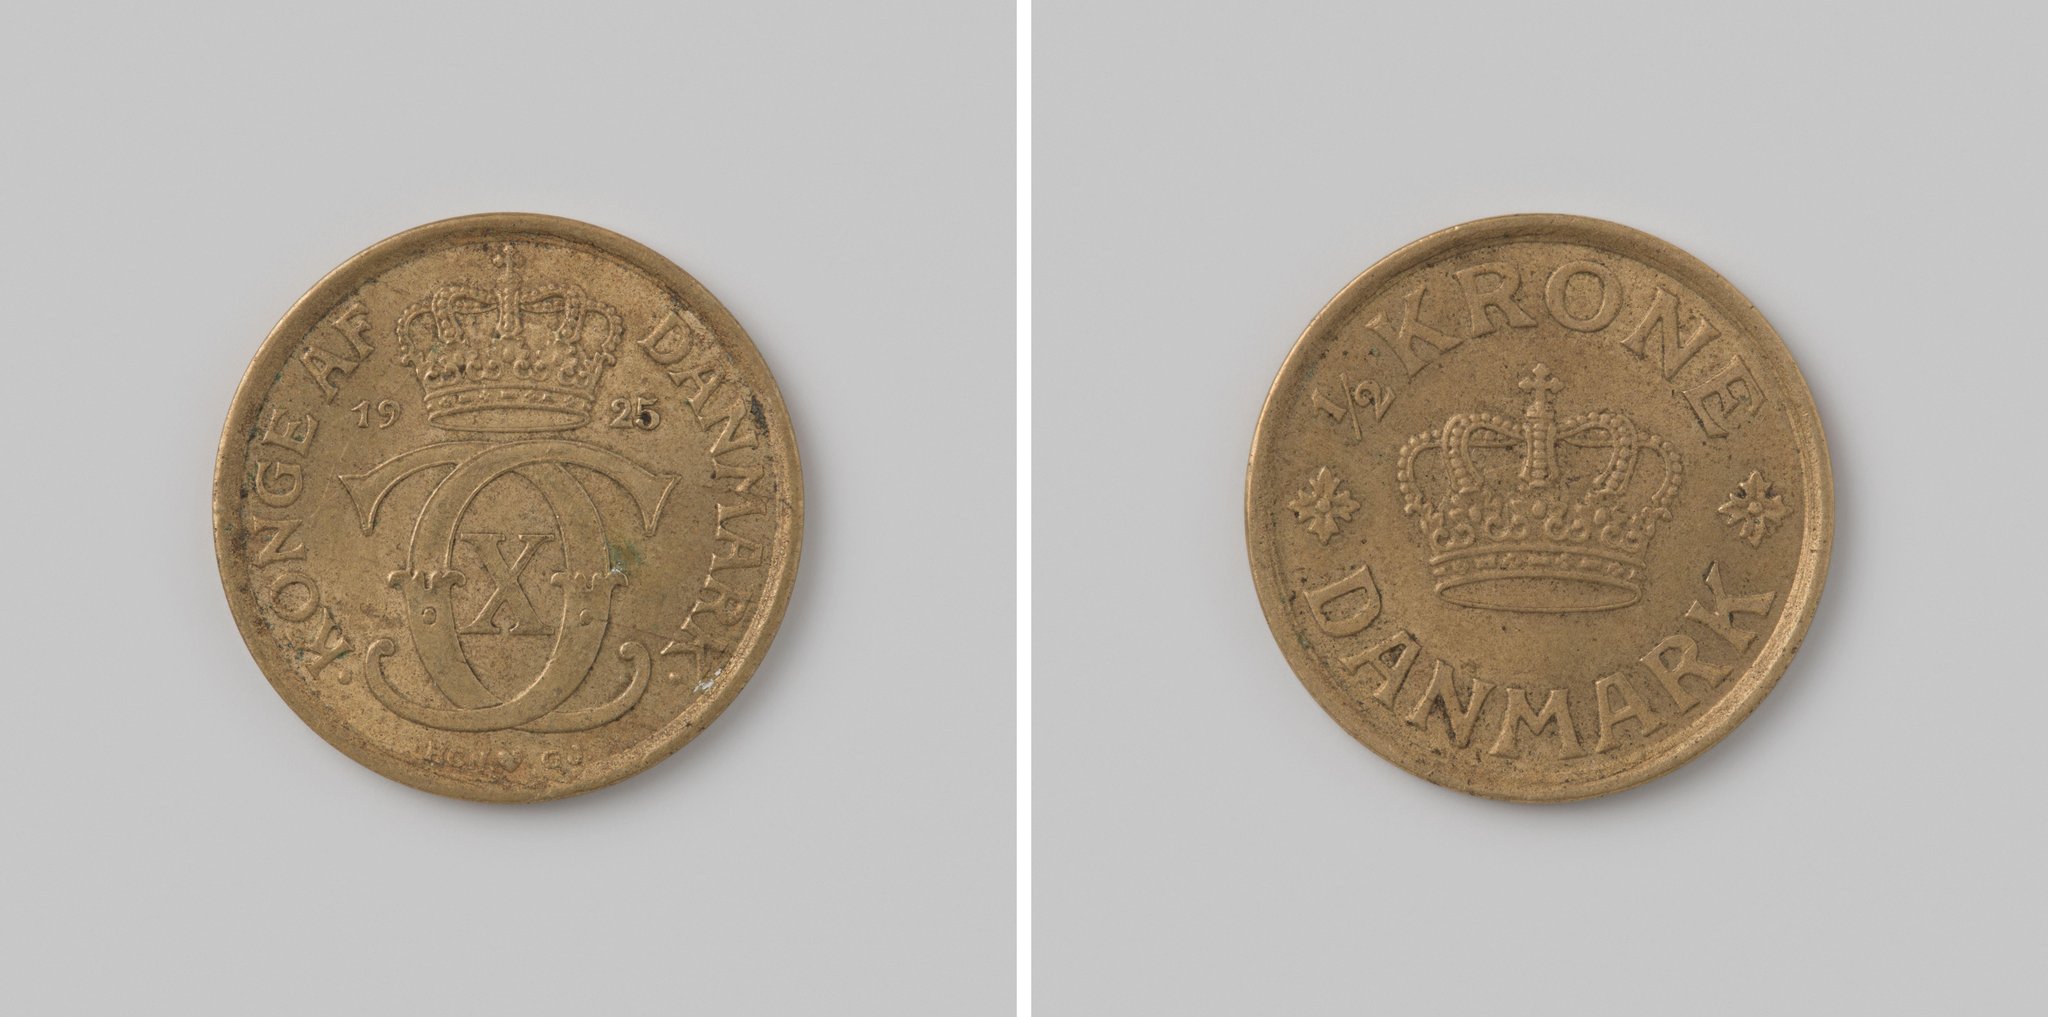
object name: coin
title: Denemarken, Christiaan X, ½ krone, 1925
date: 1925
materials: bronze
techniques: striking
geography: copenhagen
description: Aluminium-bronzen munt. Voorzijde: tussen jaartal gekroond monogram van de koning. Keerzijde: kroon in veld. Waarde-aanduiding bovenaan in omschrift. Gladde rand.